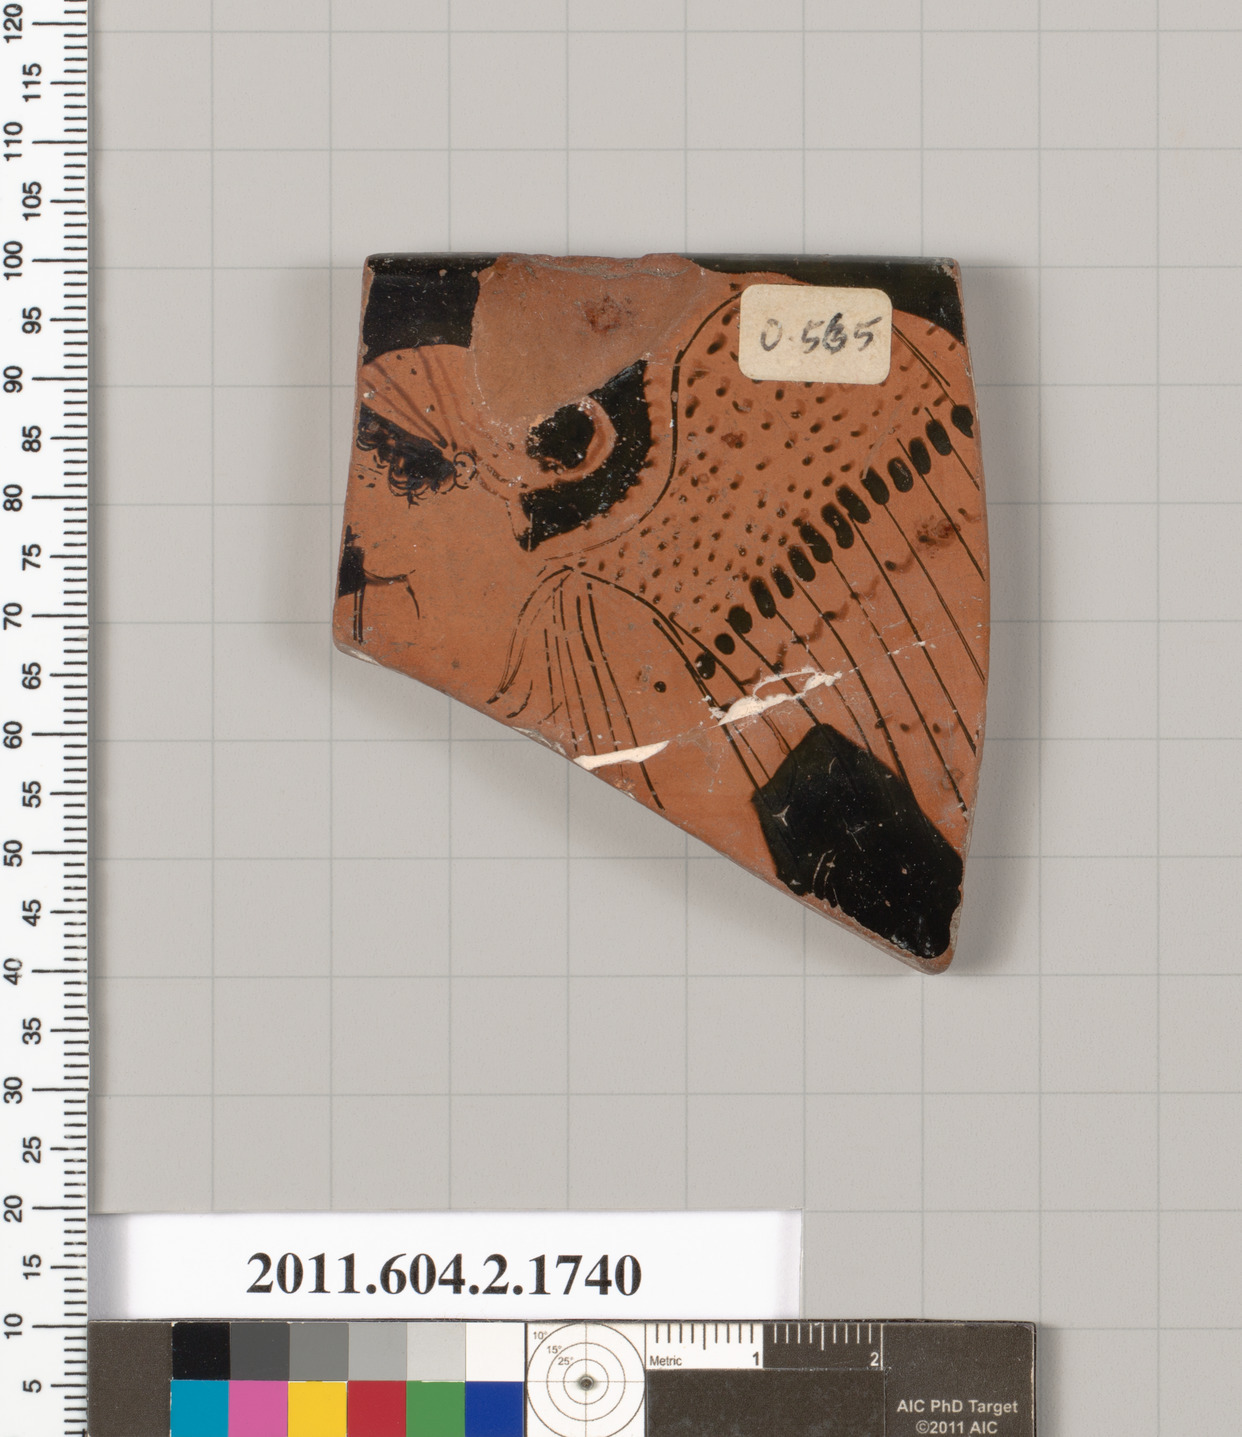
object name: skyphos fragment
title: Terracotta rim fragment of a skyphos (deep drinking cup)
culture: greek, attic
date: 460-450 BCE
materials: terracotta